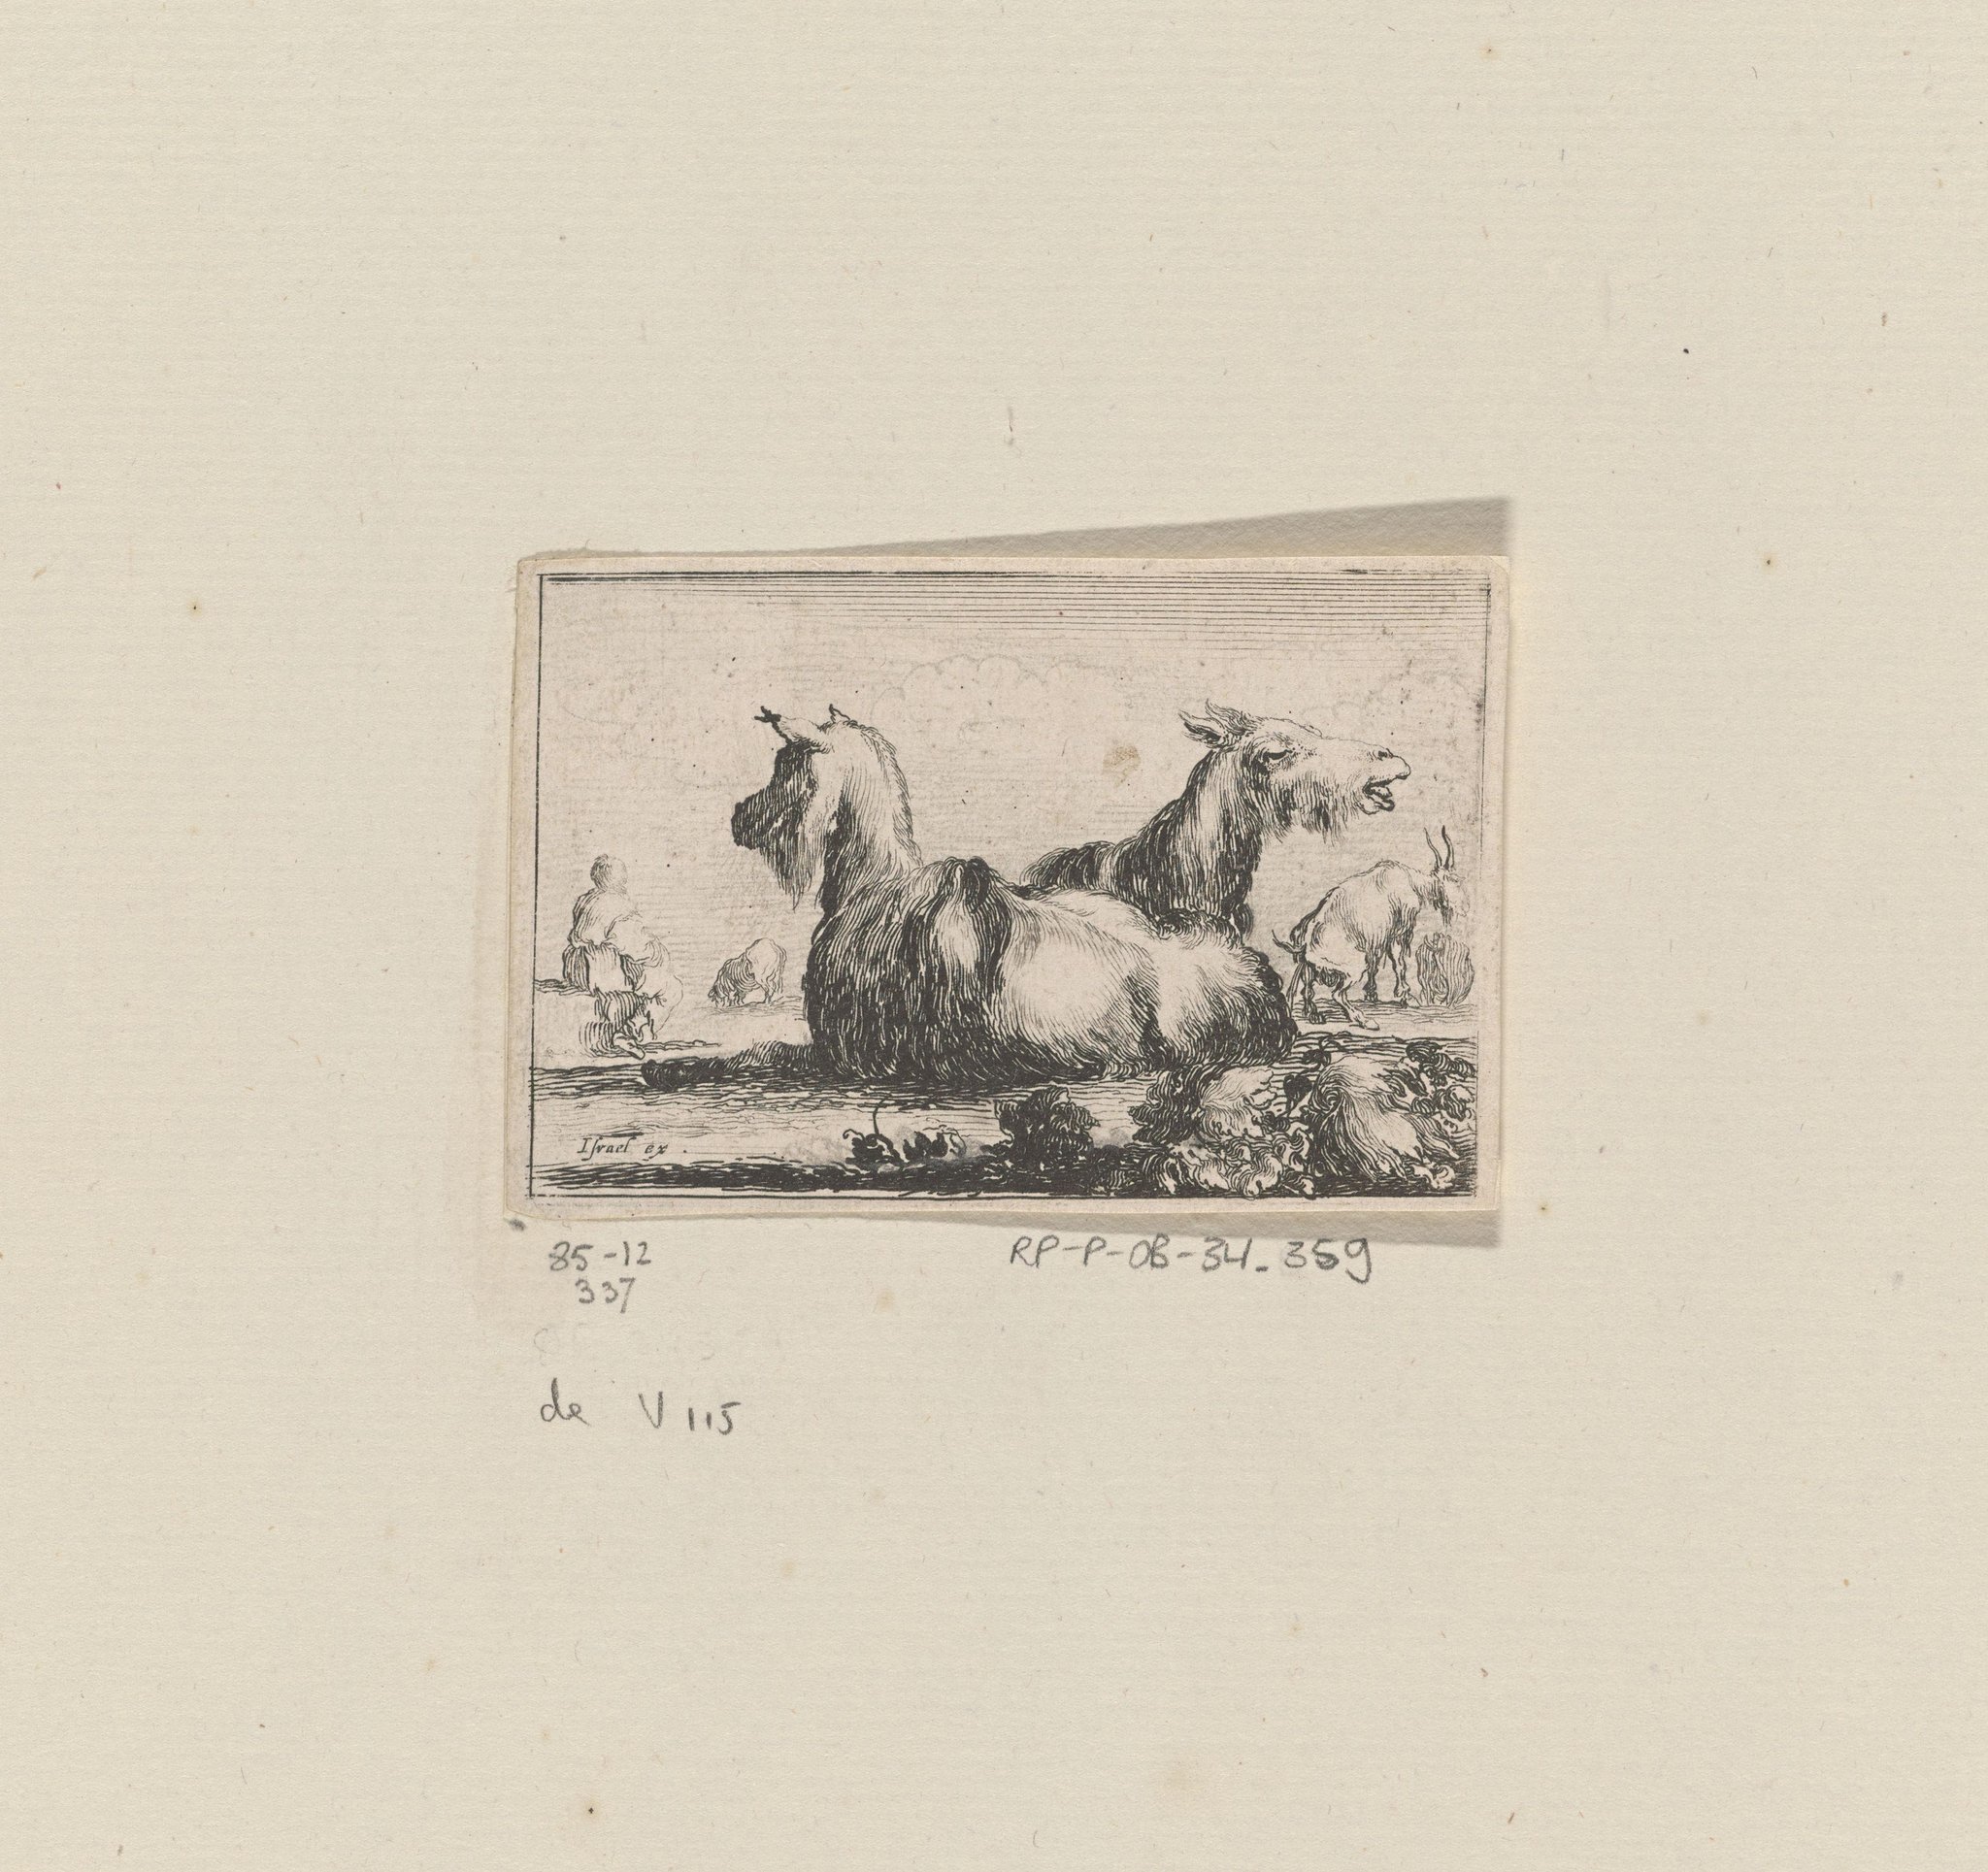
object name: print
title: Caprice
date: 1620-1664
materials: paper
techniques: etching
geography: paris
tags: goat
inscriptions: collector's mark: Lugt 240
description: Twee liggende geiten. Op de achtergrond rechts een derde geit die staat te poepen. Links een figuur op een muurtje.